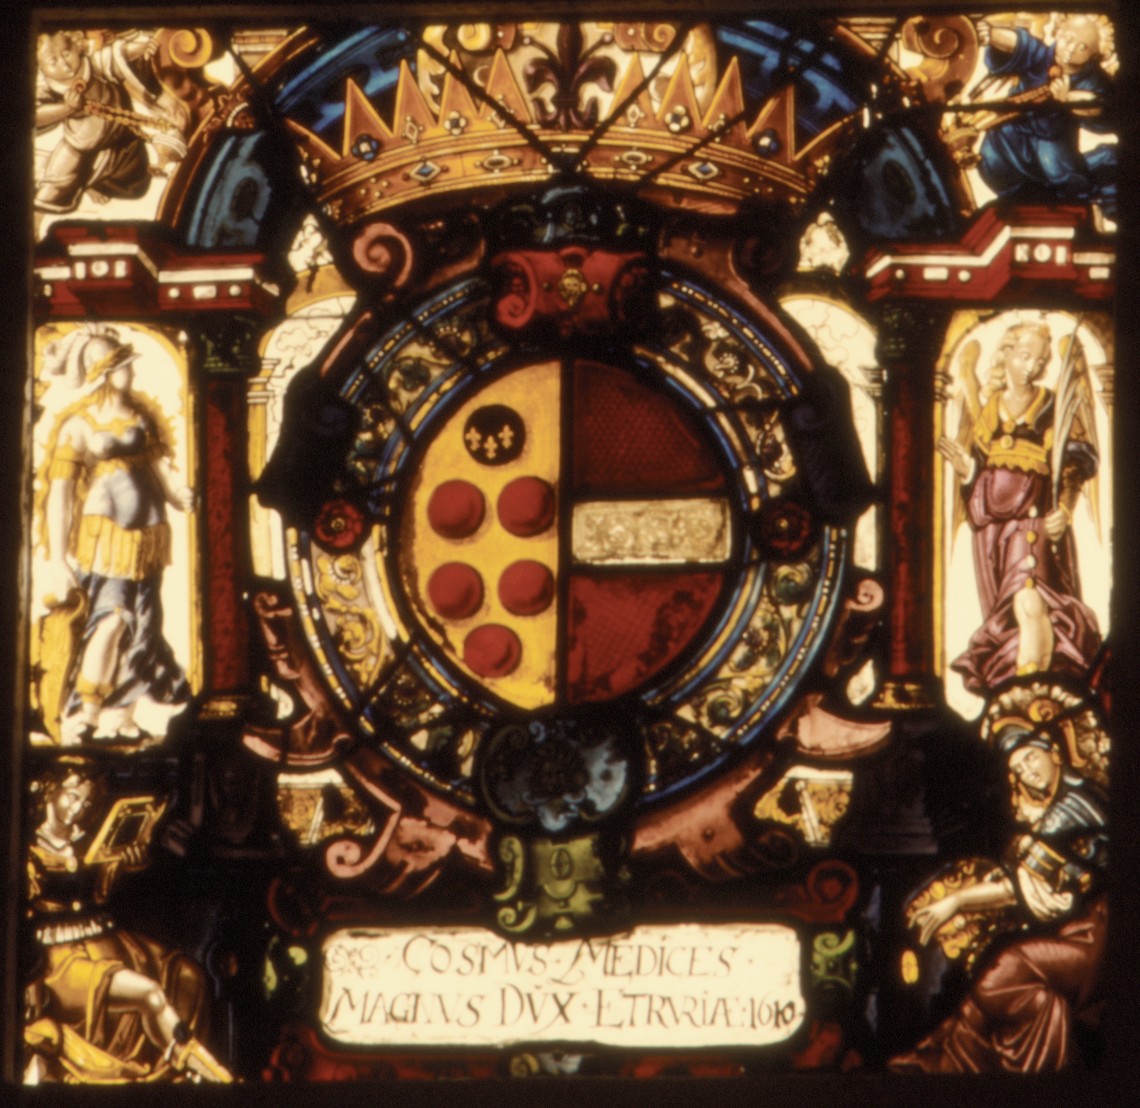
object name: armorial panel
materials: glass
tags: women,coat of arms